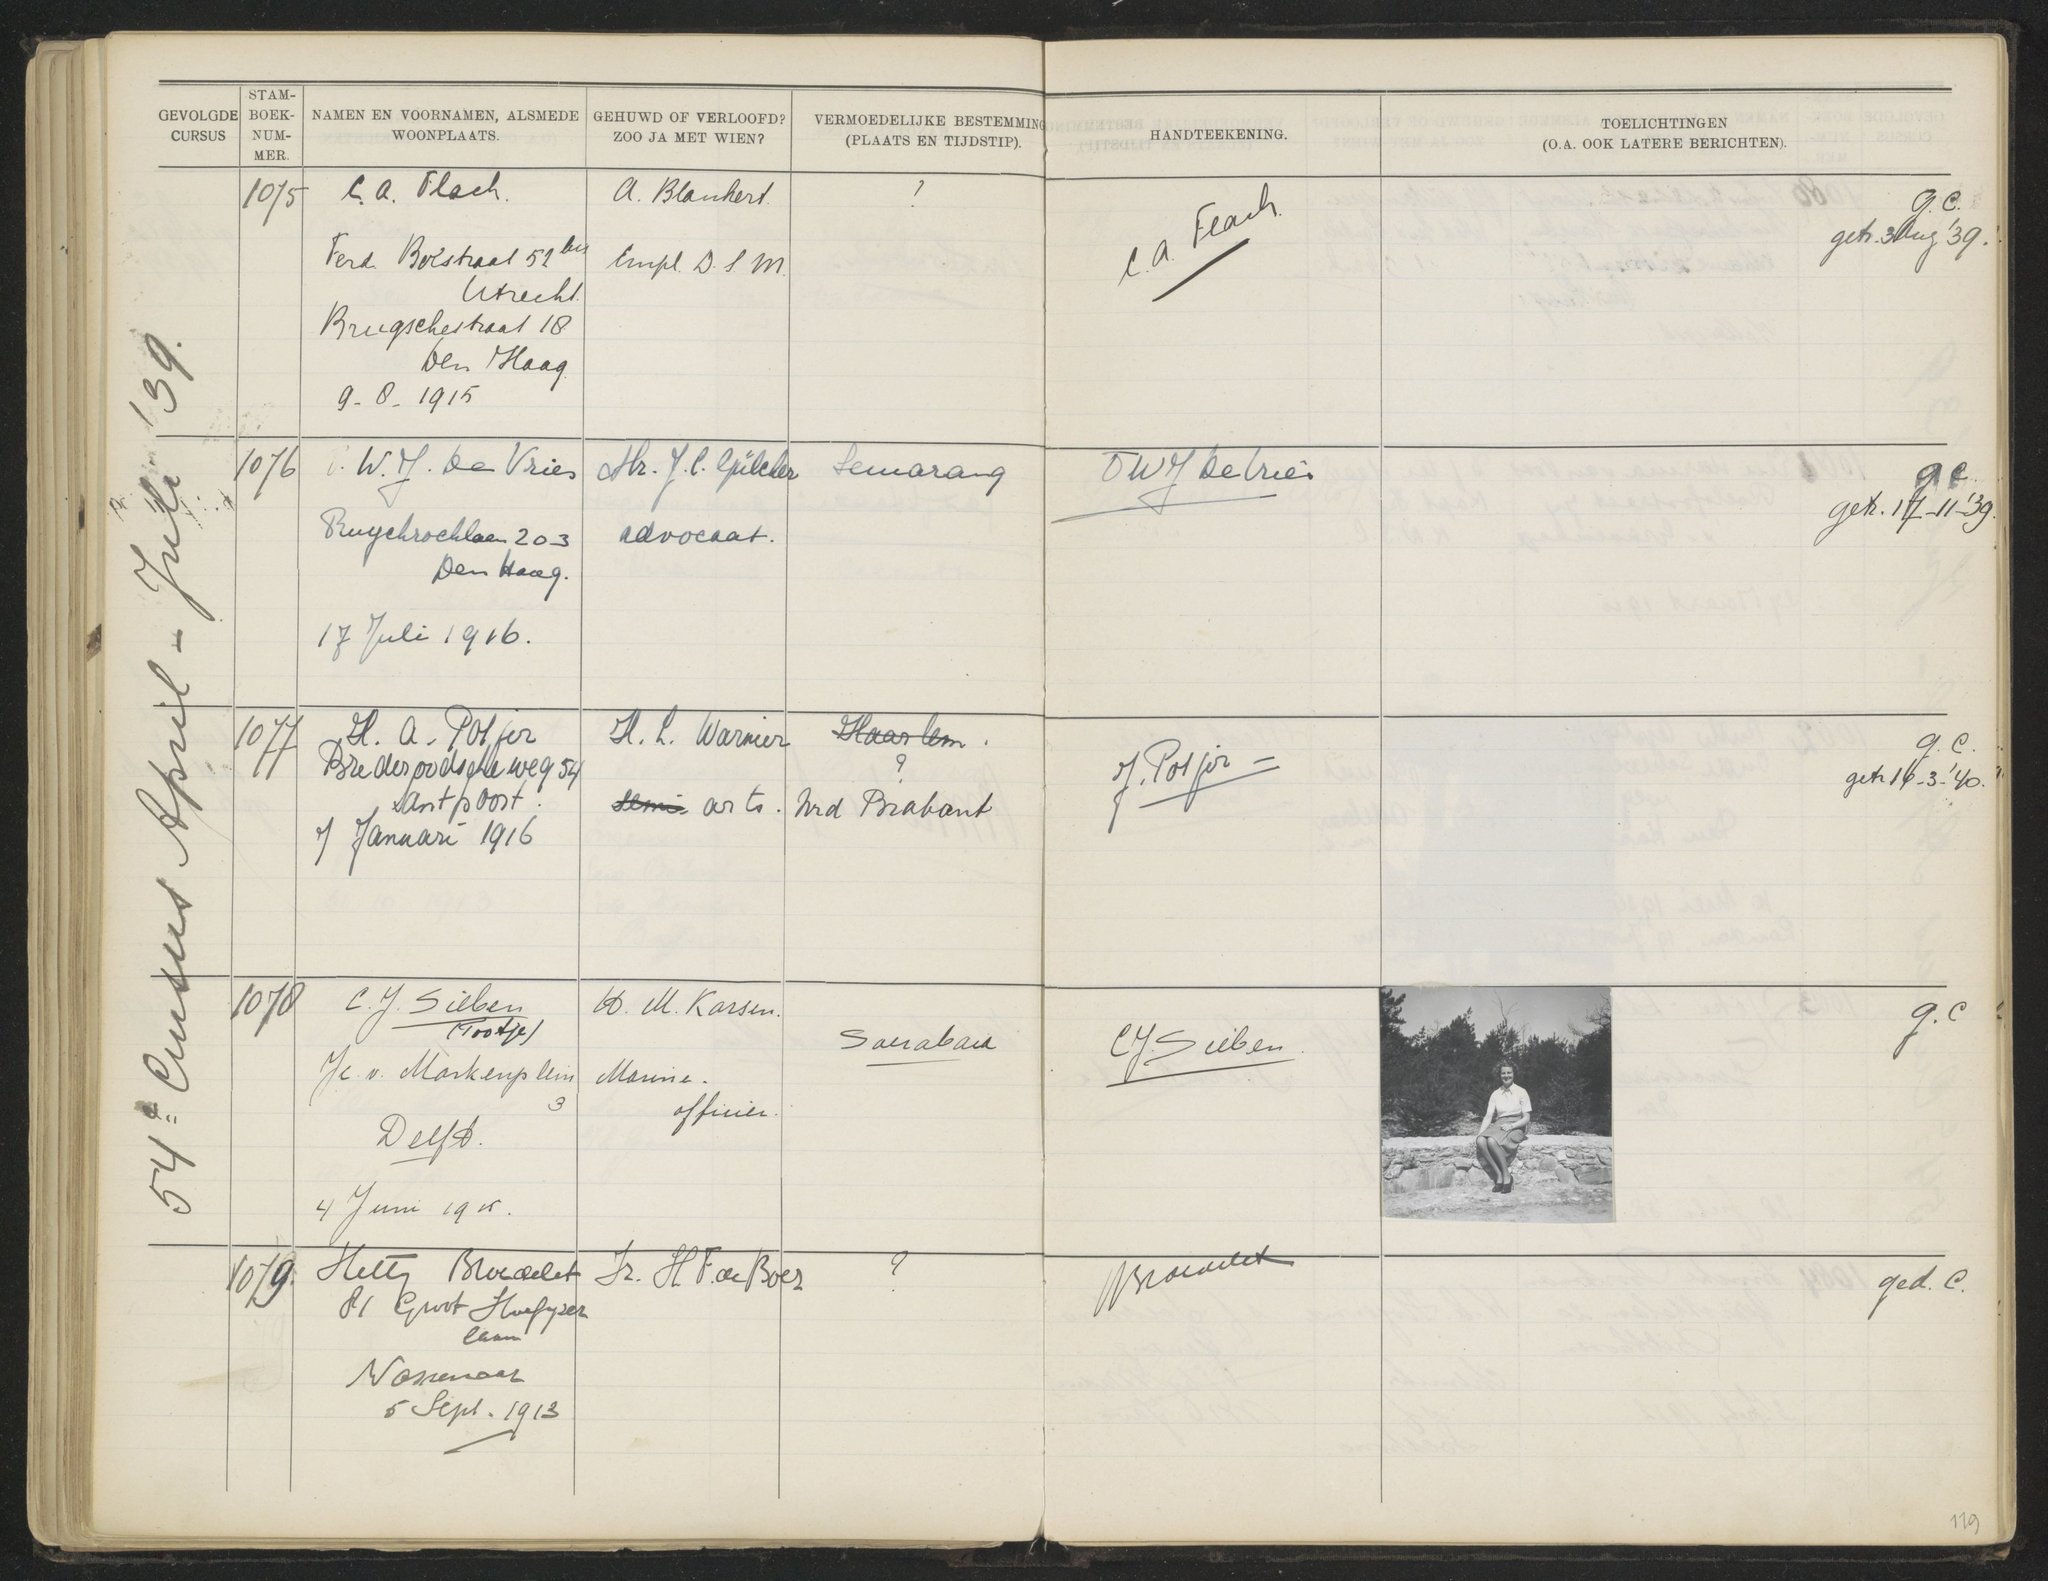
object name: photograph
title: Blad 119 uit Stamboek van de leerlingen der Koloniale School voor Meisjes en Vrouwen te 's-Gravenhage deel II (1930-1949)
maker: Anonymous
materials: paper, photographic support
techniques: photography, printing, writing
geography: the hague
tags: further education (+ pupil), further education, the hague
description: Twee pagina's met gegevens van de deelnemers aan de 54e driemaandelijkse cursus van april tot juli 1939, stamboeknummers 1075 tot en met 1079. Onderdeel van Stamboek van de leerlingen der Koloniale School voor Meisjes en Vrouwen te 's-Gravenhage deel II (1930-1949).